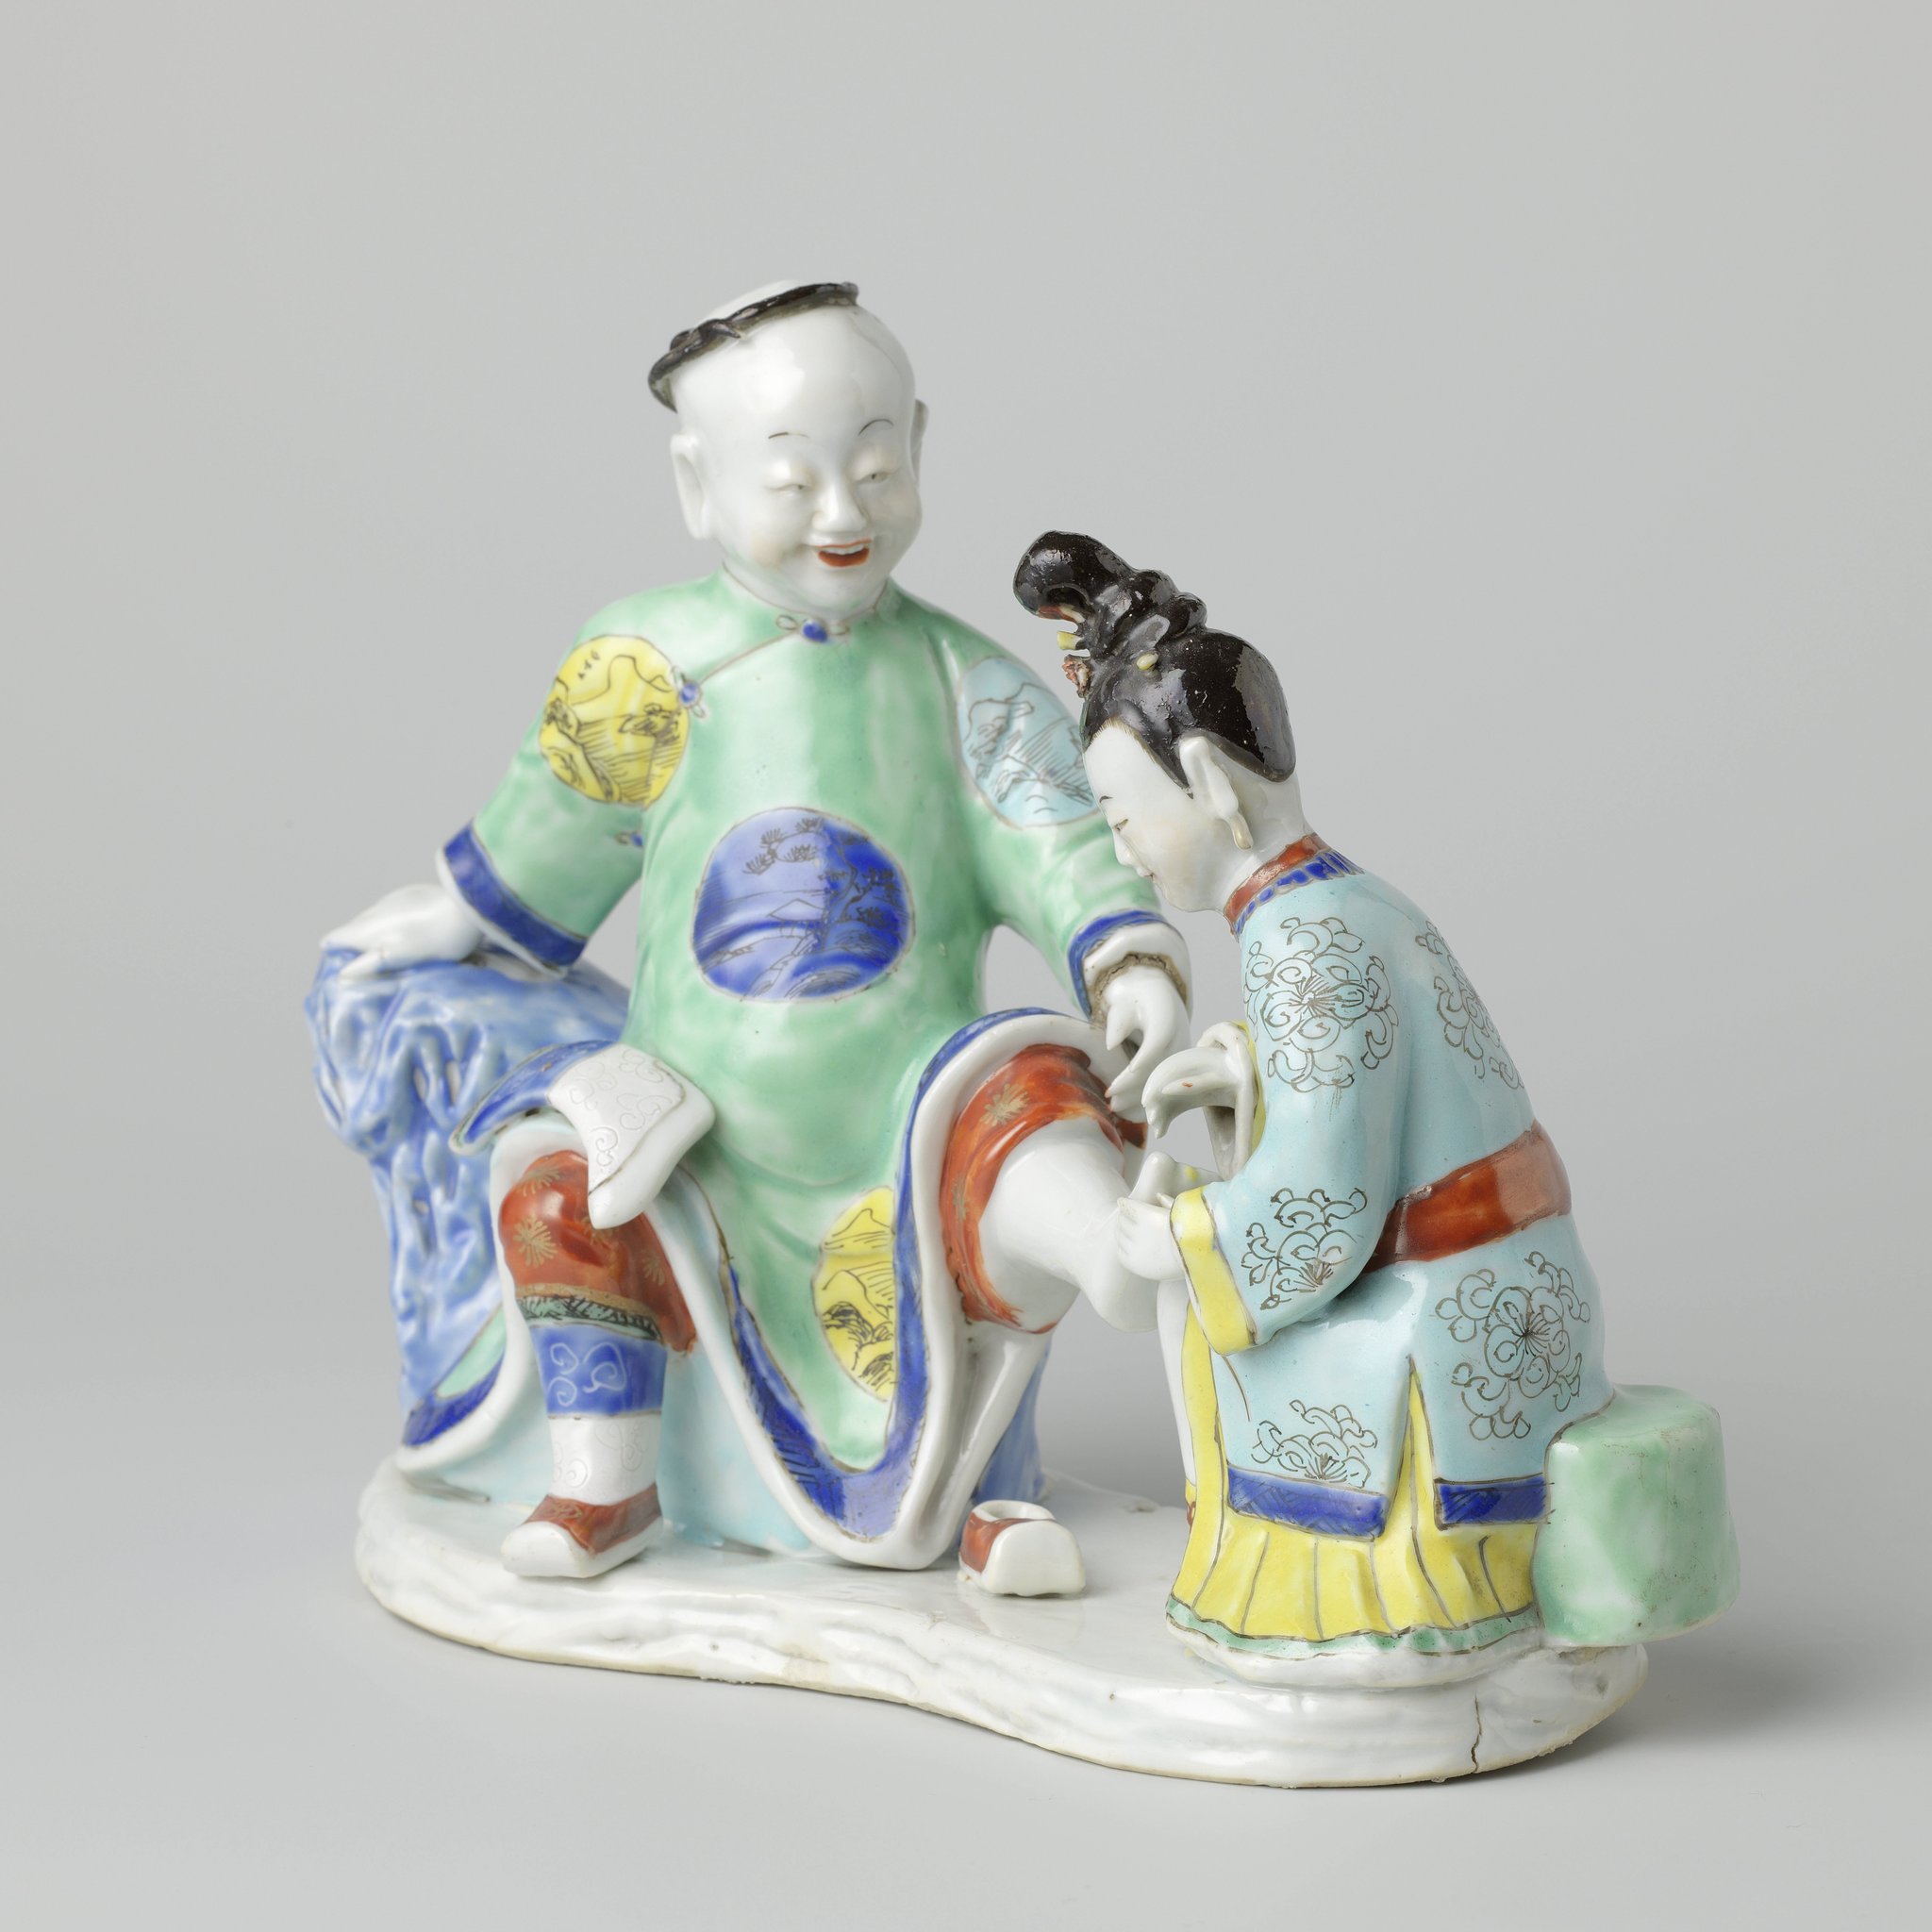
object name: figure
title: Figure of a Chinese couple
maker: Anonymous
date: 1750-1770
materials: glaze, gold, paint, porcelain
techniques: firing, forming, gilding, vitrification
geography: china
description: Beeld van een Chinees paar van porselein op een voetstuk, beschilderd op het glazuur in blauw, turquoise, rood, groen, geel, zwart en goud. De man zit op een rots, de vrouw op een kruk naast hem. Hij heeft zijn linkerschoen uitgetrokken, die ligt tussen het stel op de grond. Zijn sok ligt op zijn rechterbeen. De man steunt met zijn blote voet op het linkerbeen van de vrouw. Haar jurk is opgetrokken tot boven de knie, waardoor haar ingebonden voet zichtbaar is. Porselein met emailkleuren.